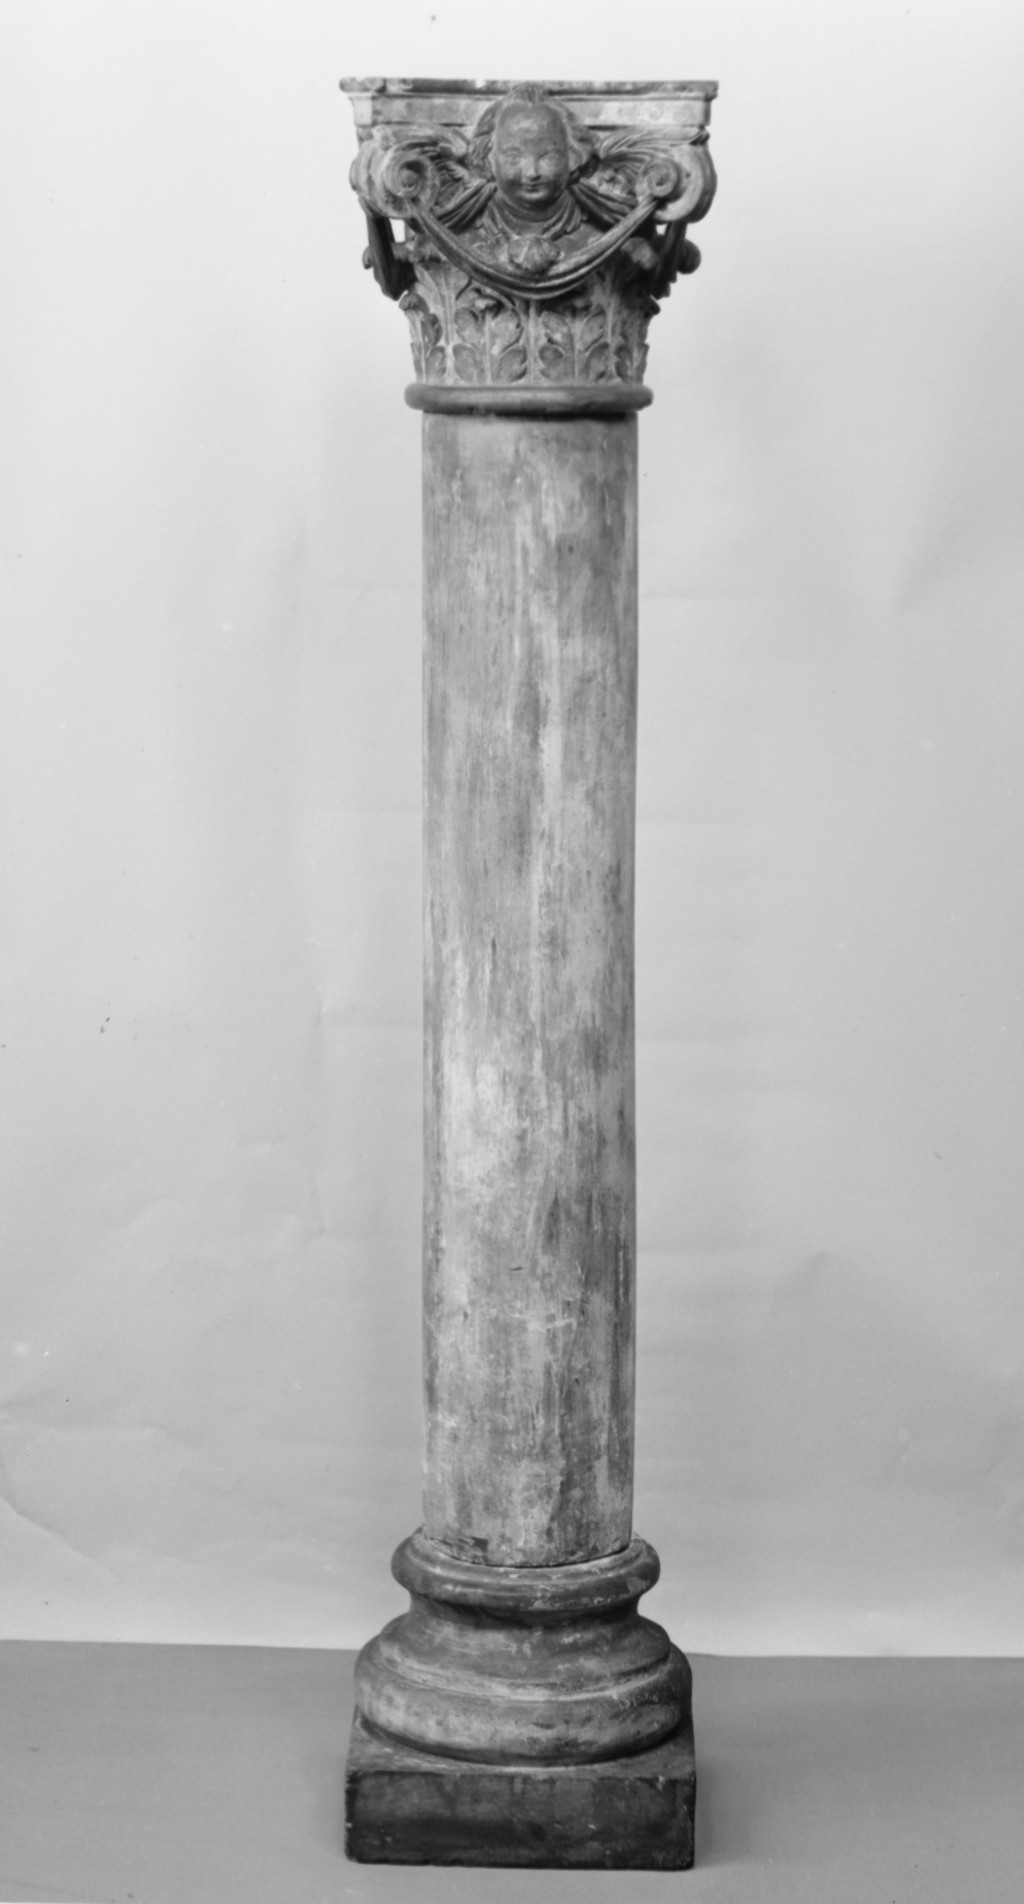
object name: column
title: Column (one of a pair)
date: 1500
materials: limestone